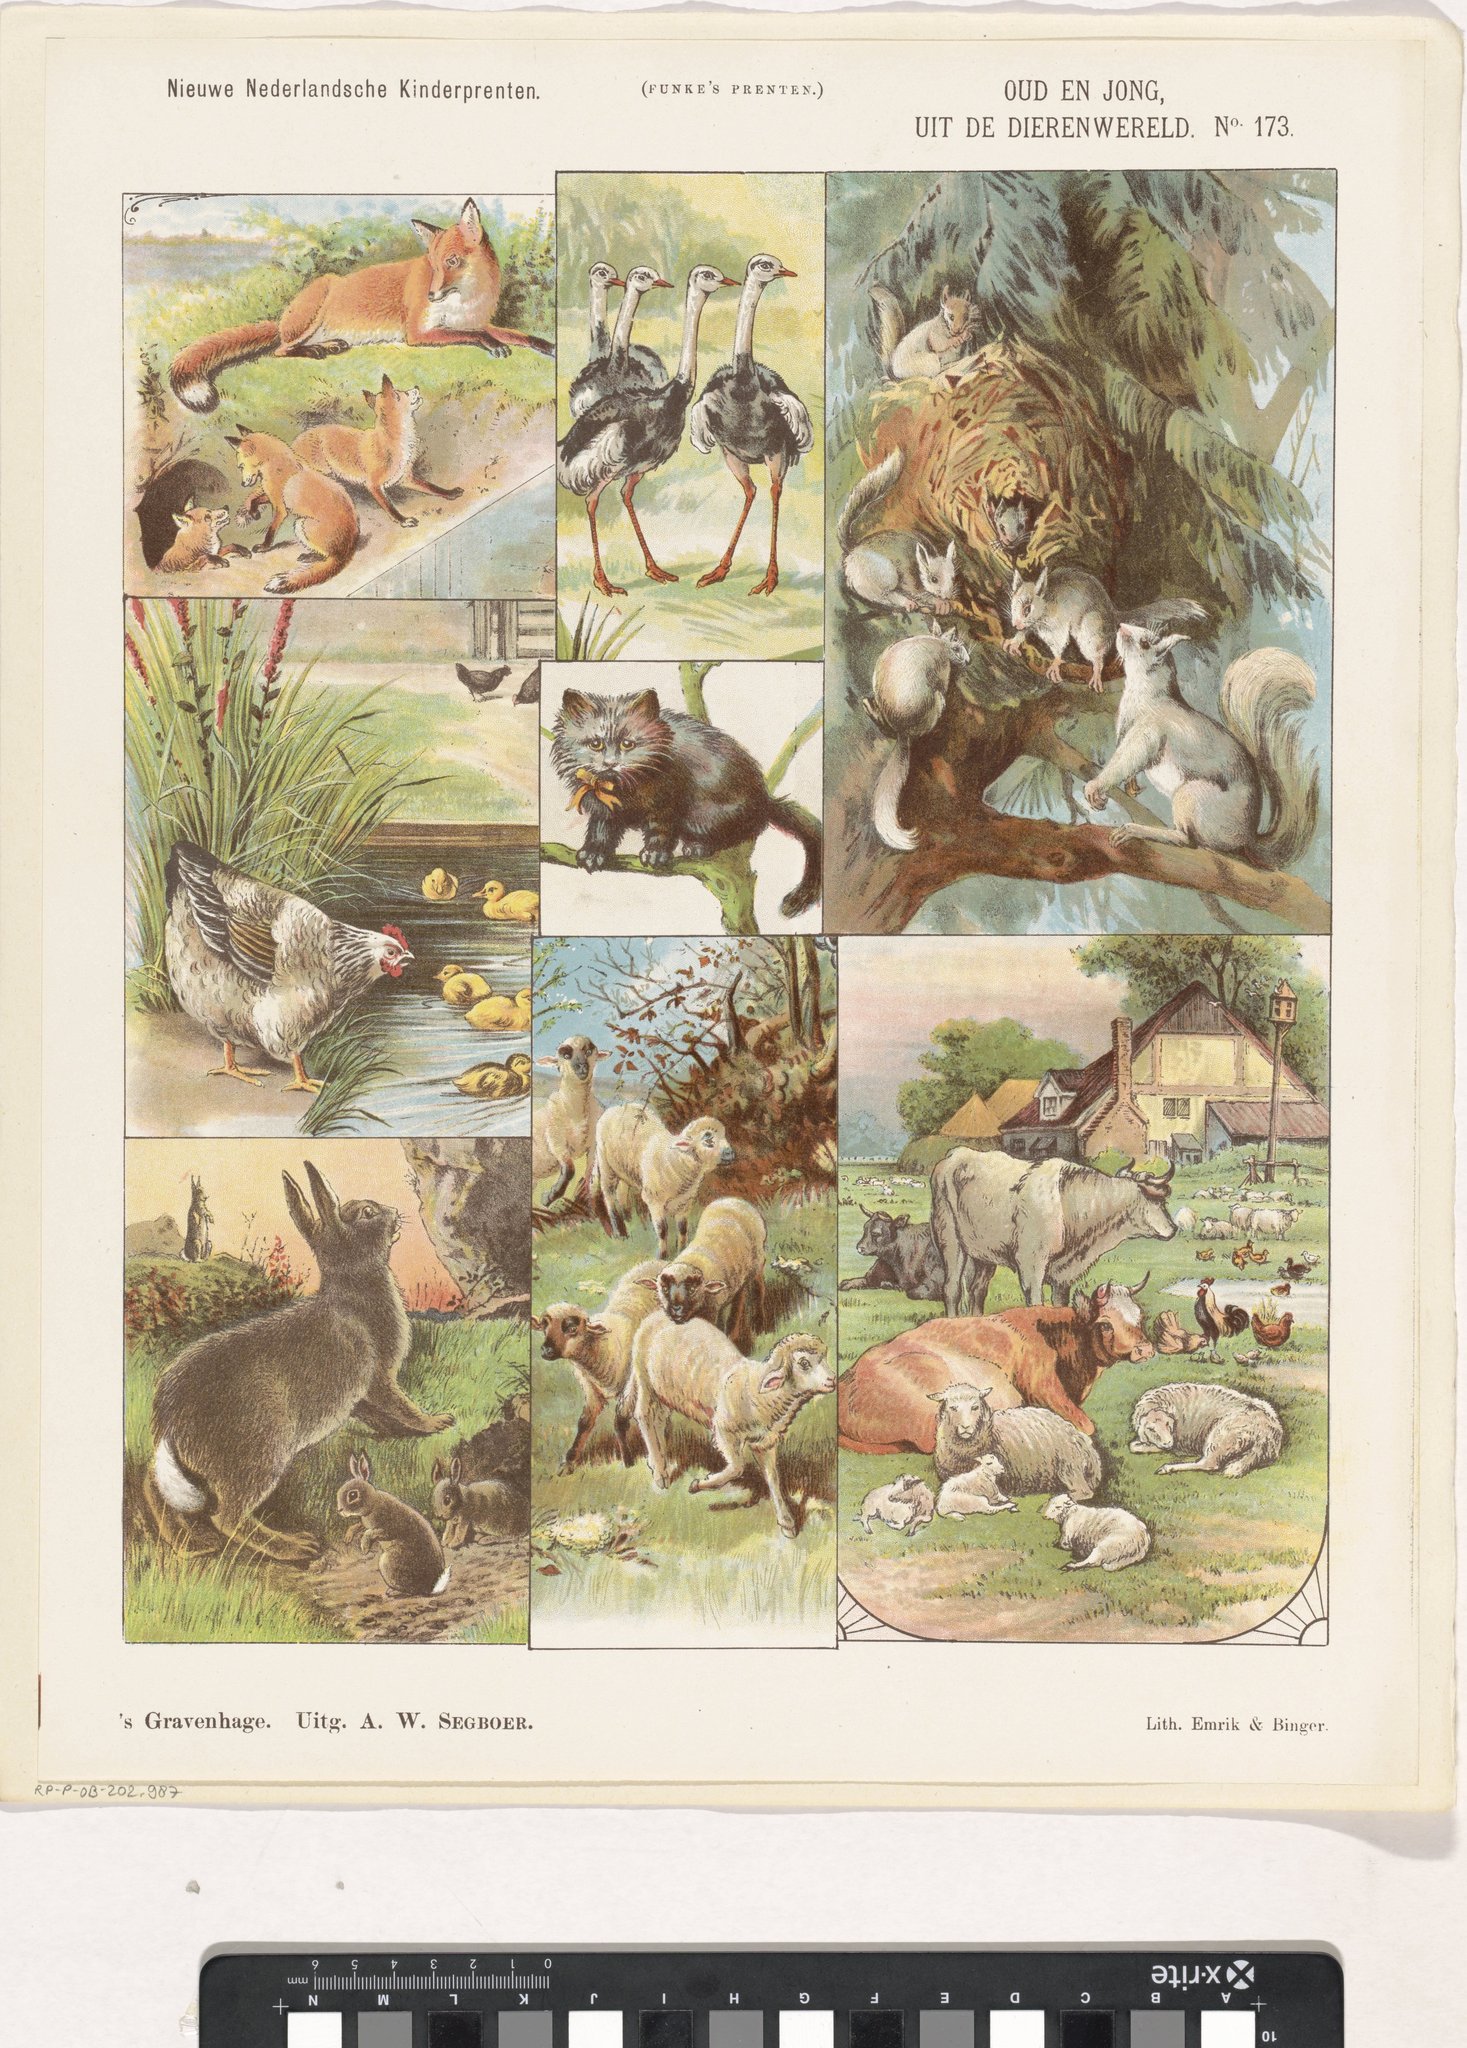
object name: print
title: Oud en jong, / uit de dierenwereld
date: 1903-1919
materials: paper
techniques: lithograph, letterpress printing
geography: haarlem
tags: cow, animals, fowl (cock, hen, chicken, etc.), rodents: rabbit, beasts of prey, predatory animals: fox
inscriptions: collector's mark: Lugt 2760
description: Blad met 8 voorstellingen van dieren met jongen, zoals vossen, eekhoorns en schapen. Genummerd rechtsboven: No. 173.